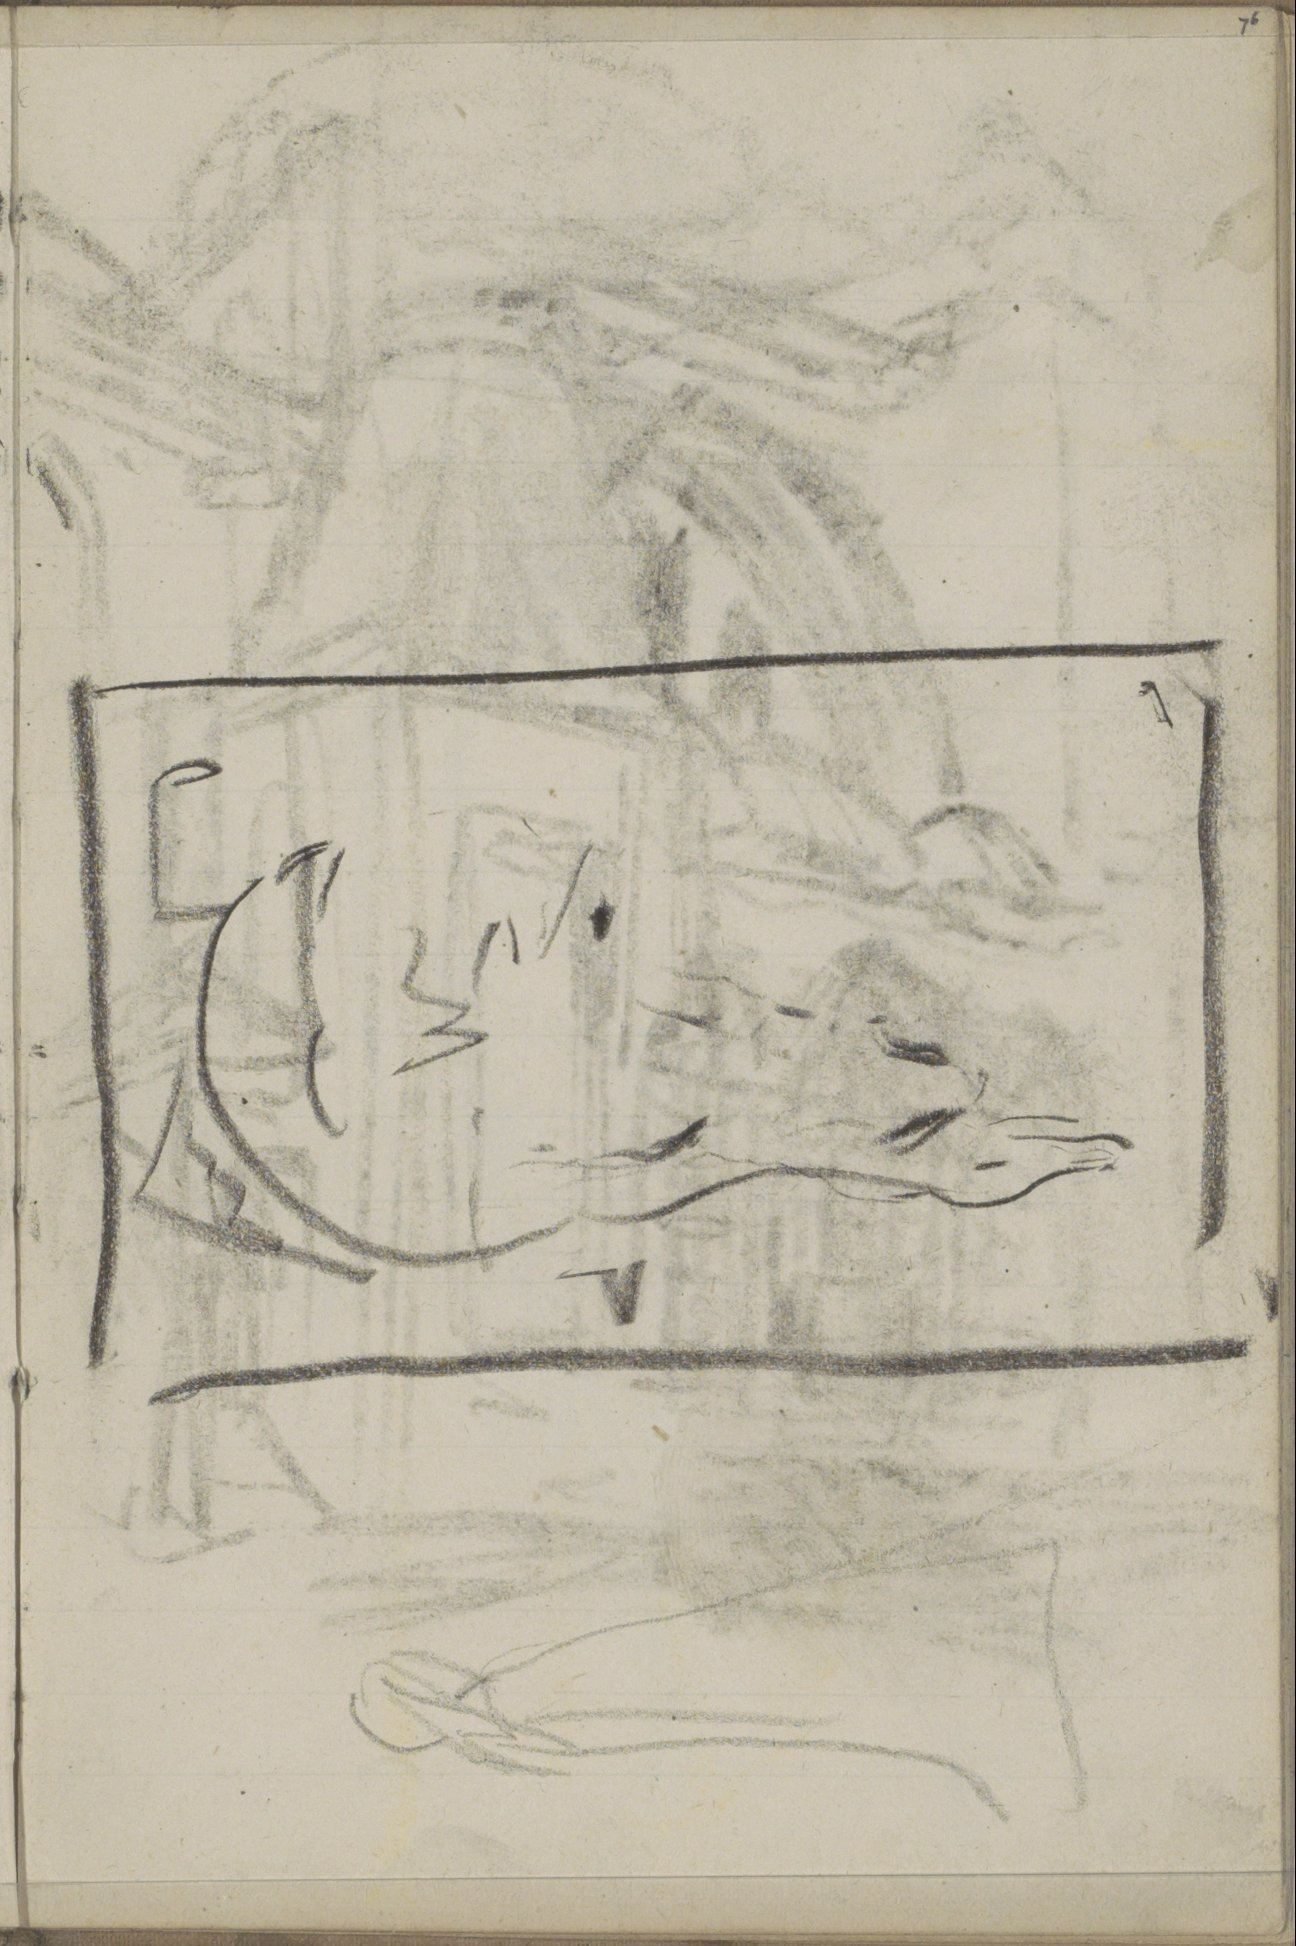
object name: sketchbook leaf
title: Studieblad, met onder andere een figuur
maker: marius bauer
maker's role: draughtsman, print maker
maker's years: 1867-1932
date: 1888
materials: chalk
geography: istanbul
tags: asiatic races and peoples, standing figure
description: De figuur draagt oosterse kleding. Pagina 76 uit een schetsboek met 56 bladen.